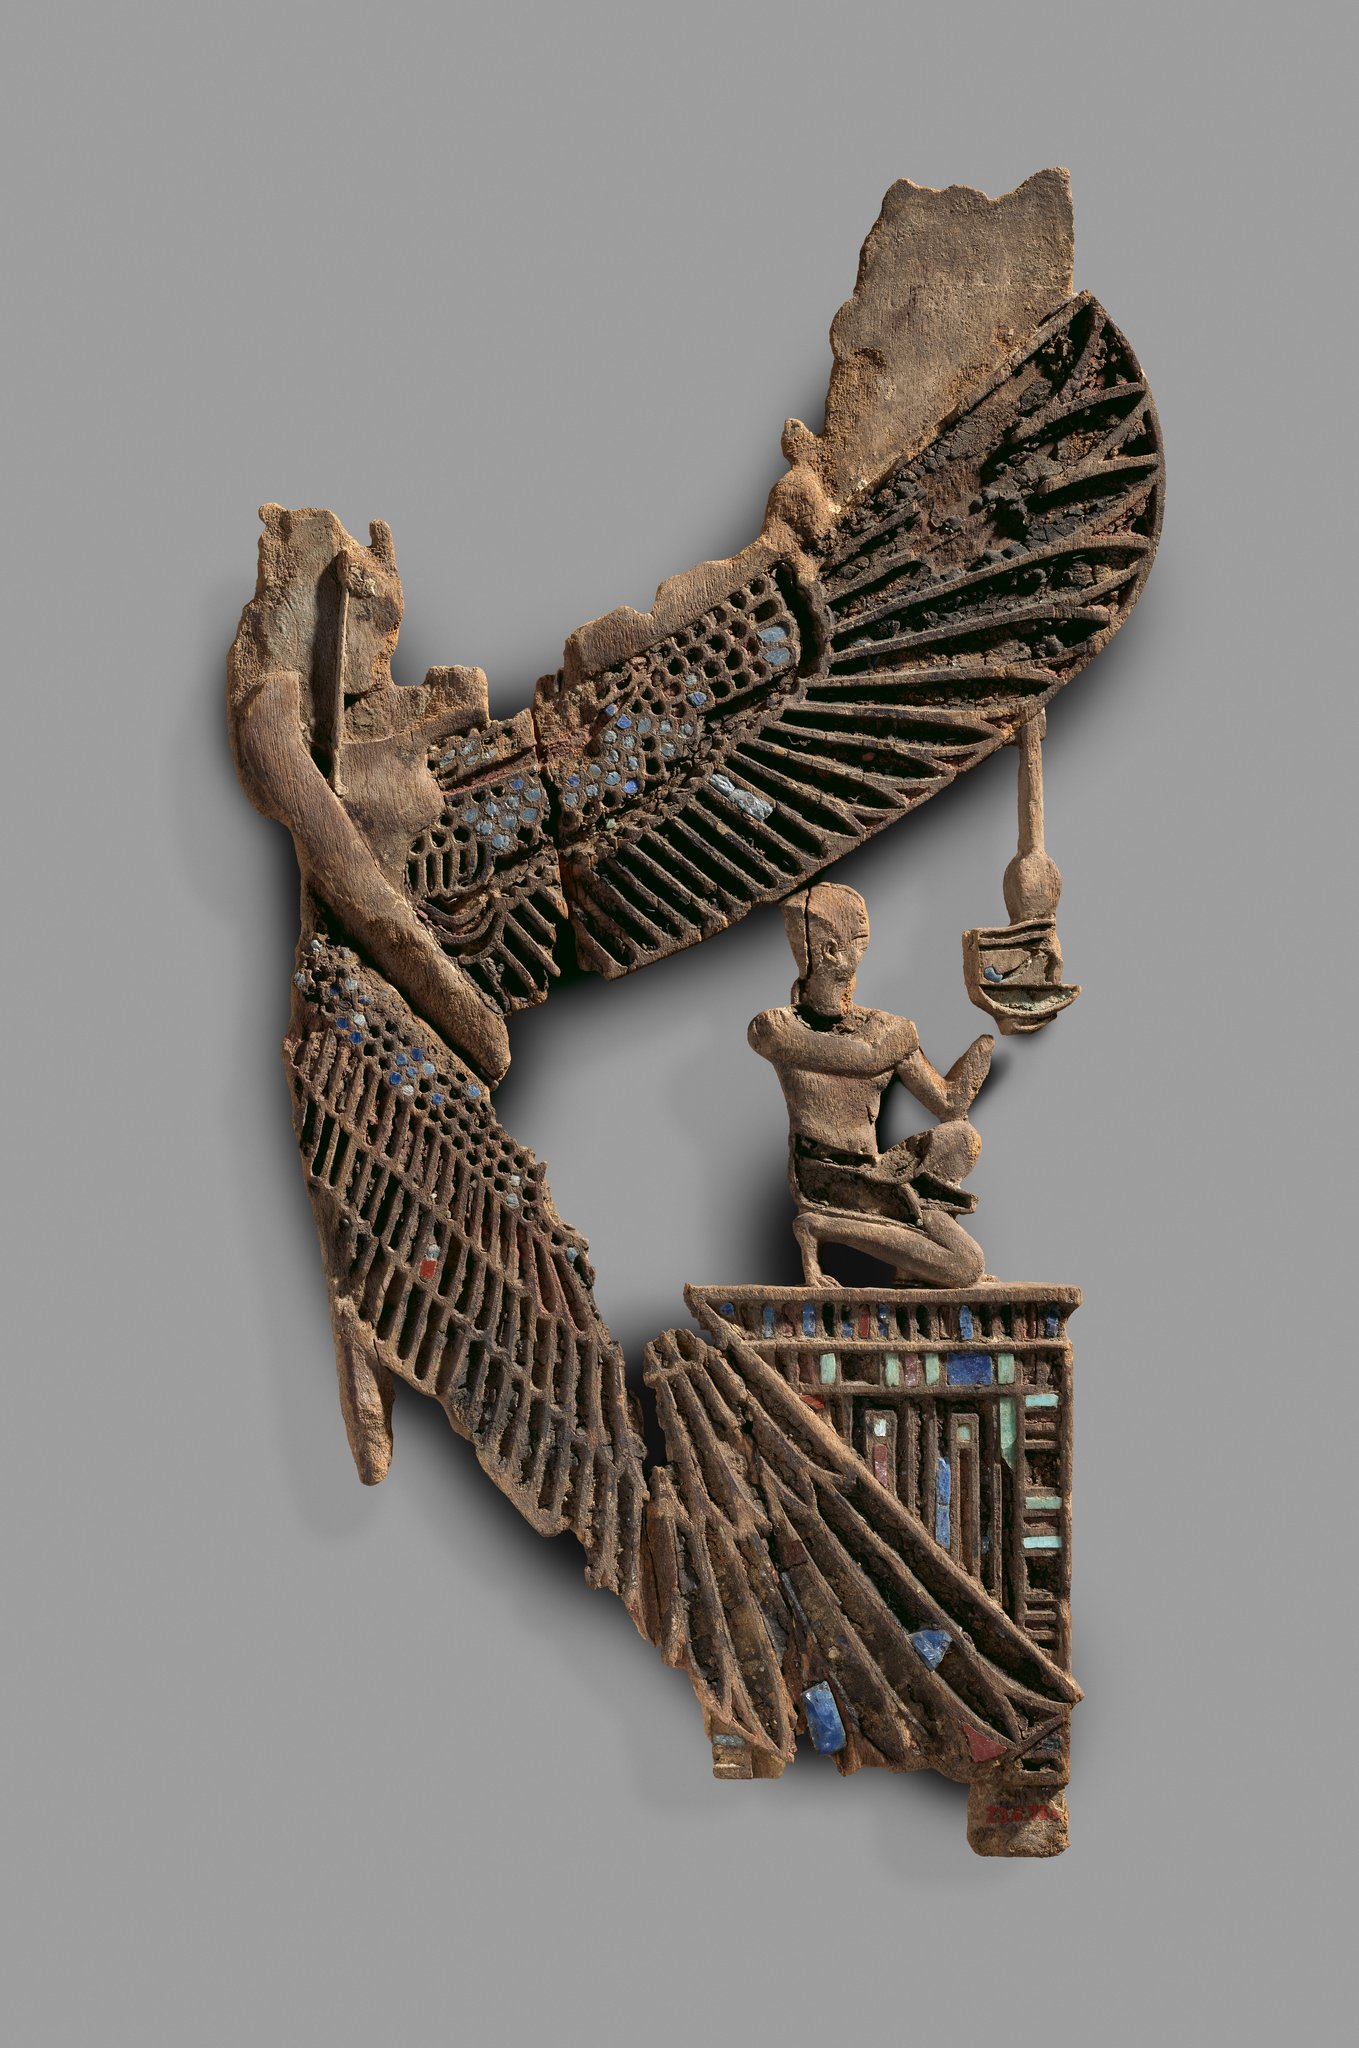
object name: inlay, panel decoration, naos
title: Section of panel from a naos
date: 522 BCE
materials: glass, wood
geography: egypt